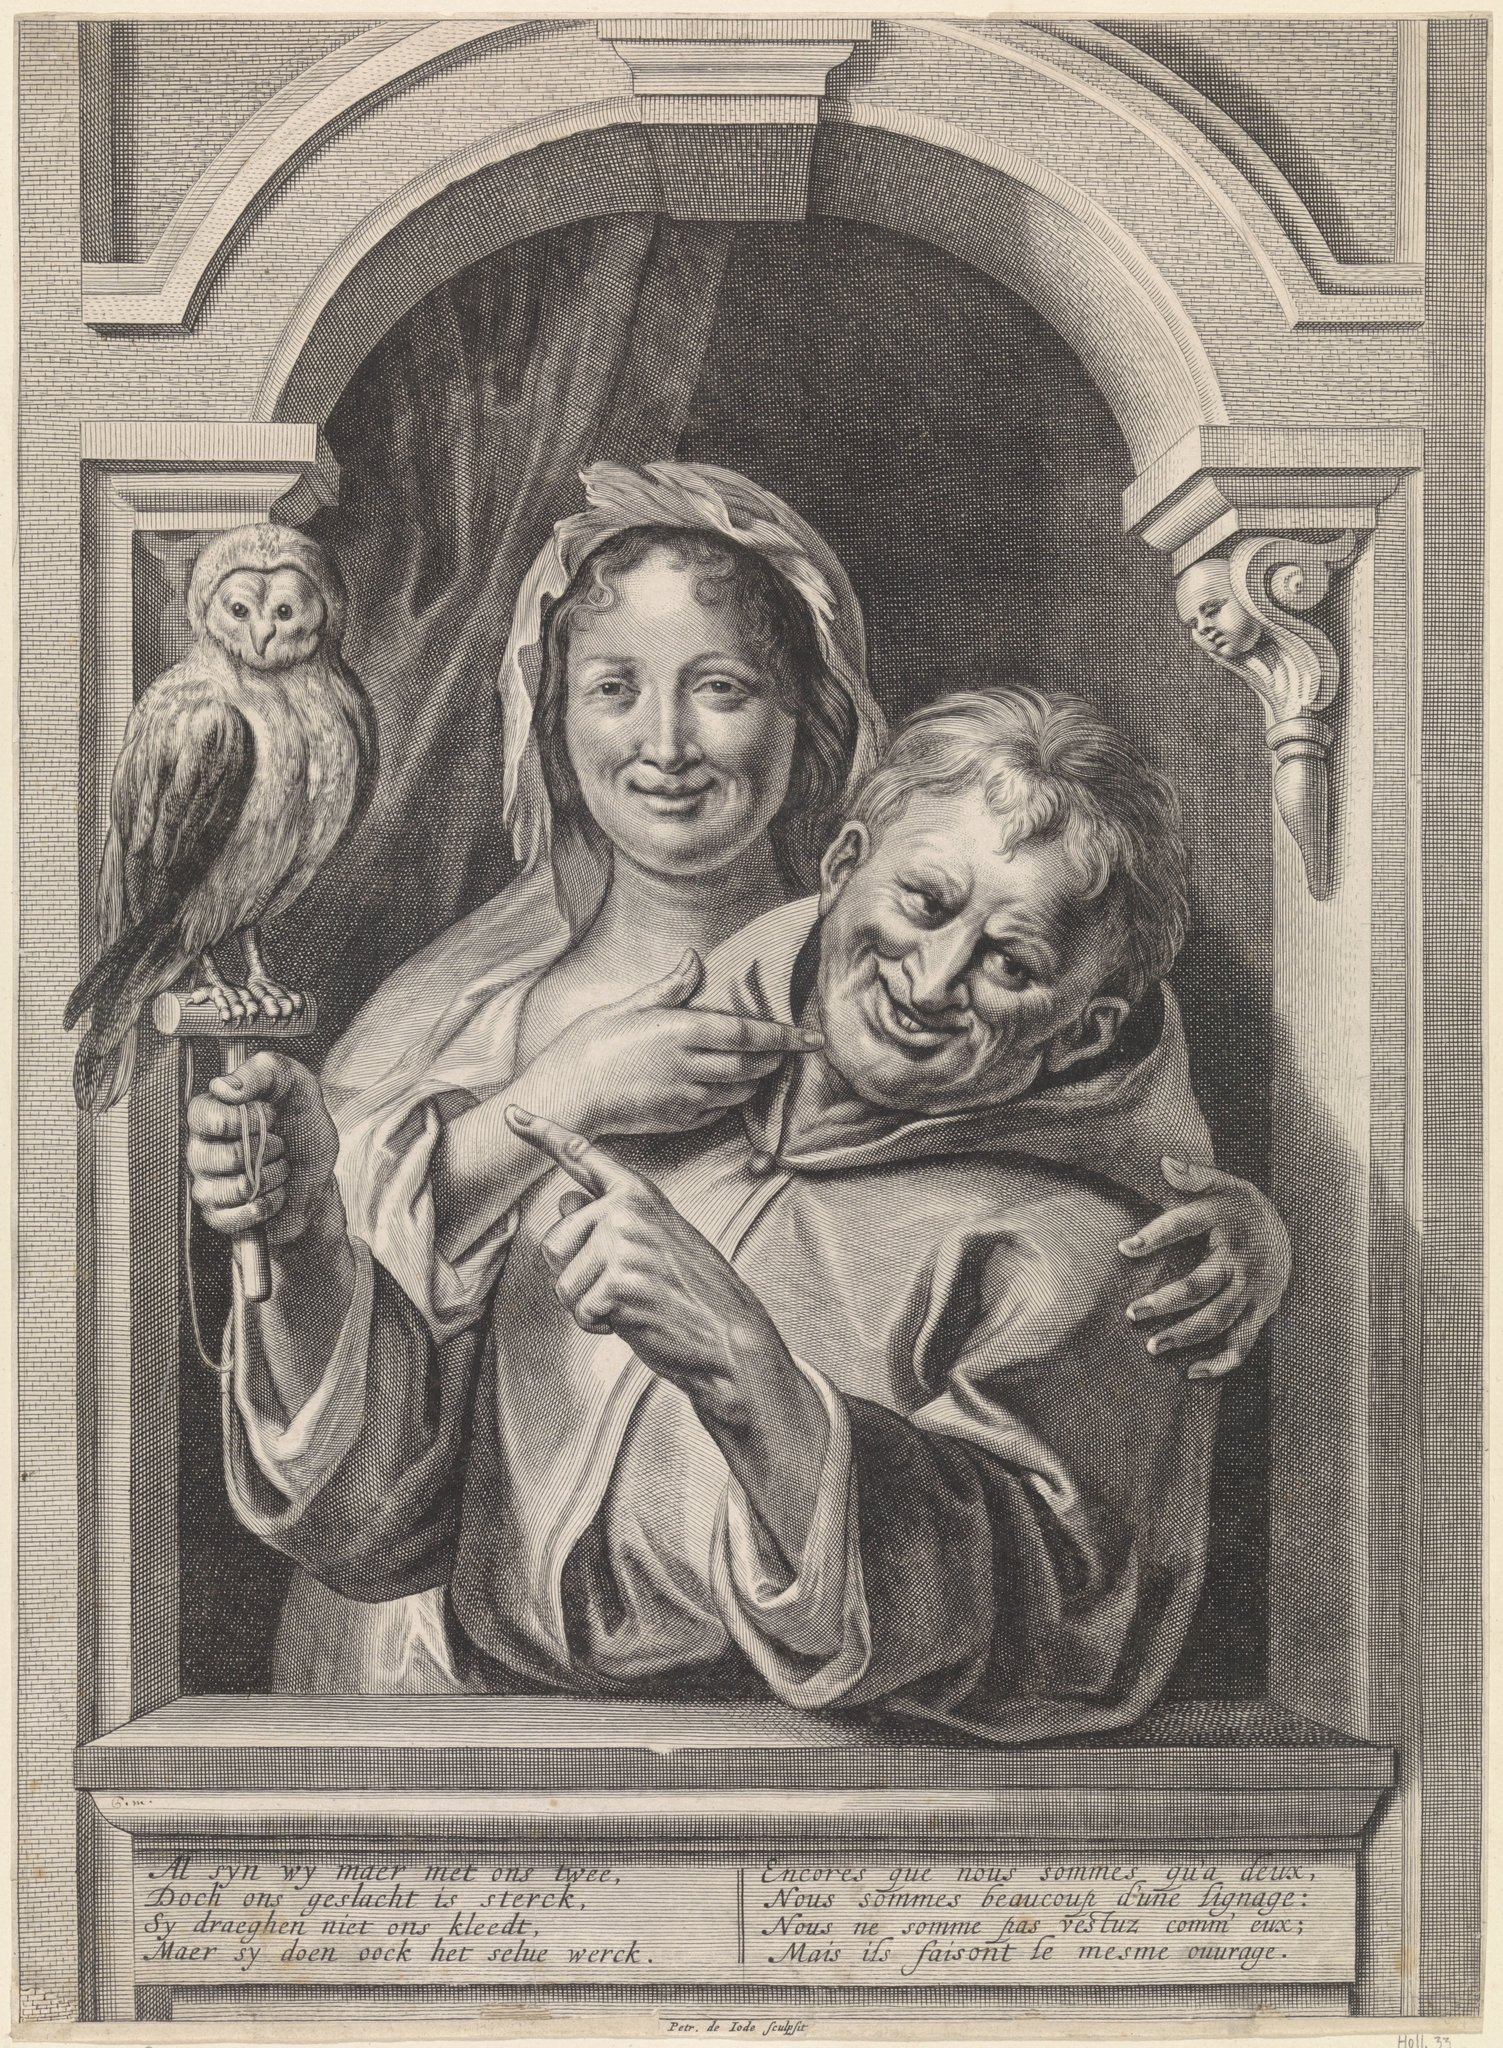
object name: print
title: Man met uil in venster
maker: pieter de jode (ii)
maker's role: draughtsman, print maker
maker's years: 1606-1674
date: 1628-1670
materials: paper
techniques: engraving, etching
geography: antwerp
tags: fool, simpleton, numskull, owls, couple of lovers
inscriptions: collector's mark: Lugt 240, inscription: ‘G.m.’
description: Een man, leunend op de vensterbank, houdt een stok met daarop een uil in de hand. Met zijn linkerhand wijst hij naar de uil. Achter hem staat een vrouw, met haar arm om hem heen geslagen. In een kader onder het venster een vierregelig onderschrift in het Nederlands en het Frans.